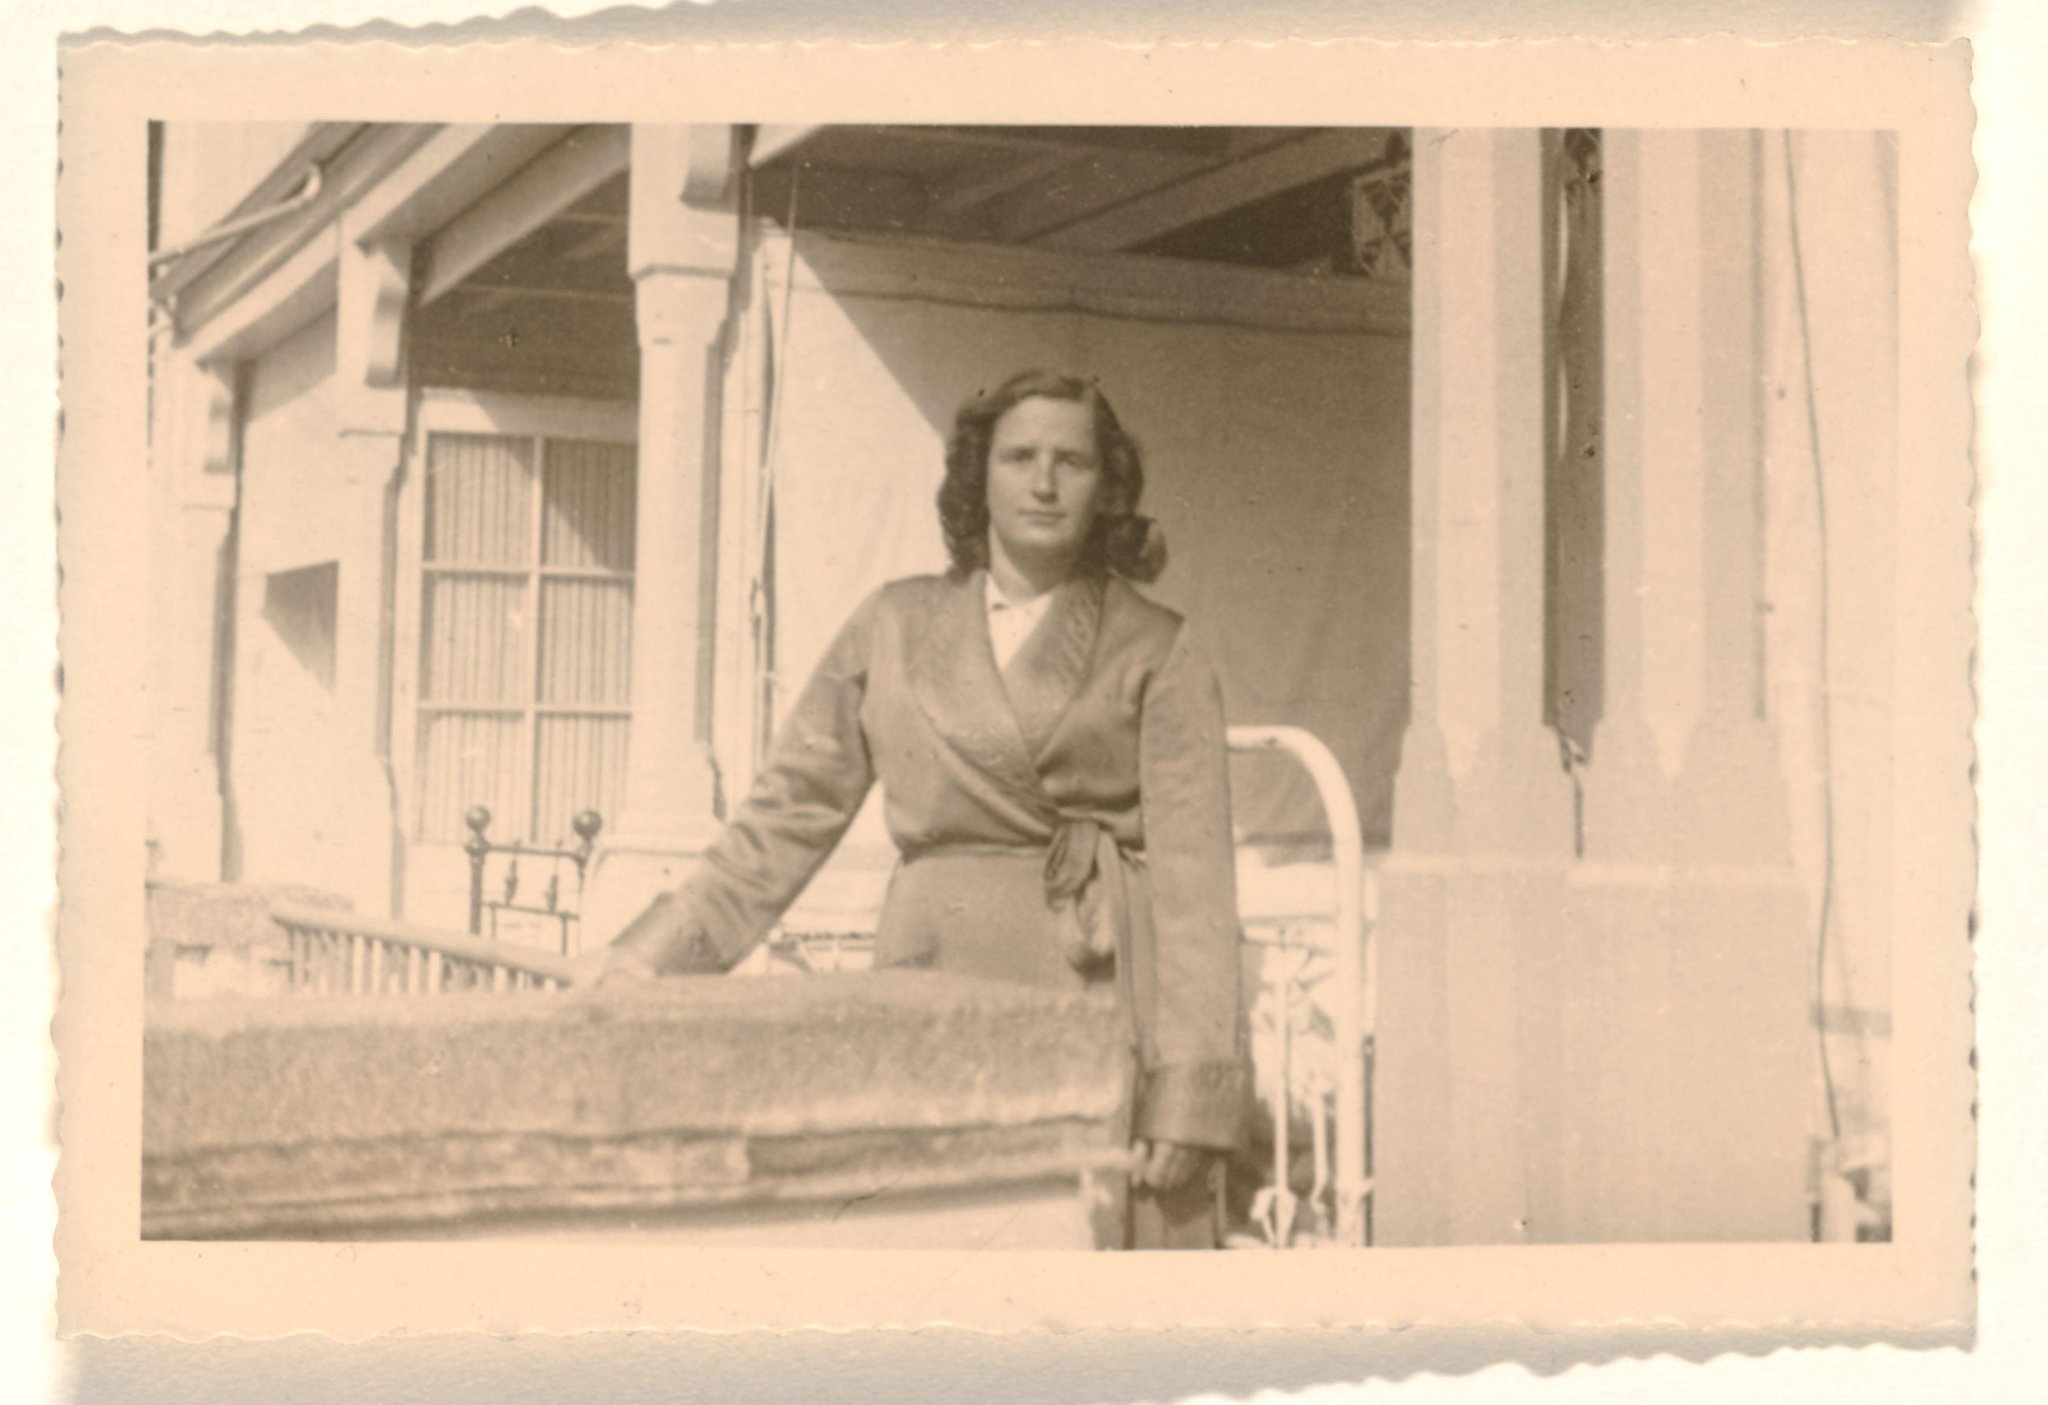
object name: photograph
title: Isabel Wachenheimer in kamerjas staand voor de toegang tot een openlucht ziekenhuiskamer in het Joods sanatorium Etania in Davos, april 1946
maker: Anonymous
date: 1904-1946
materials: photographic support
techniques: gelatin silver print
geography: davos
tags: leiden, isabel wachenheimer-elon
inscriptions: number: ‘13a’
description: Isabel Wachenheimer in kamerjas staand voor de toegang tot een openlucht ziekenhuiskamer in het Joods sanatorium Etania in Davos.